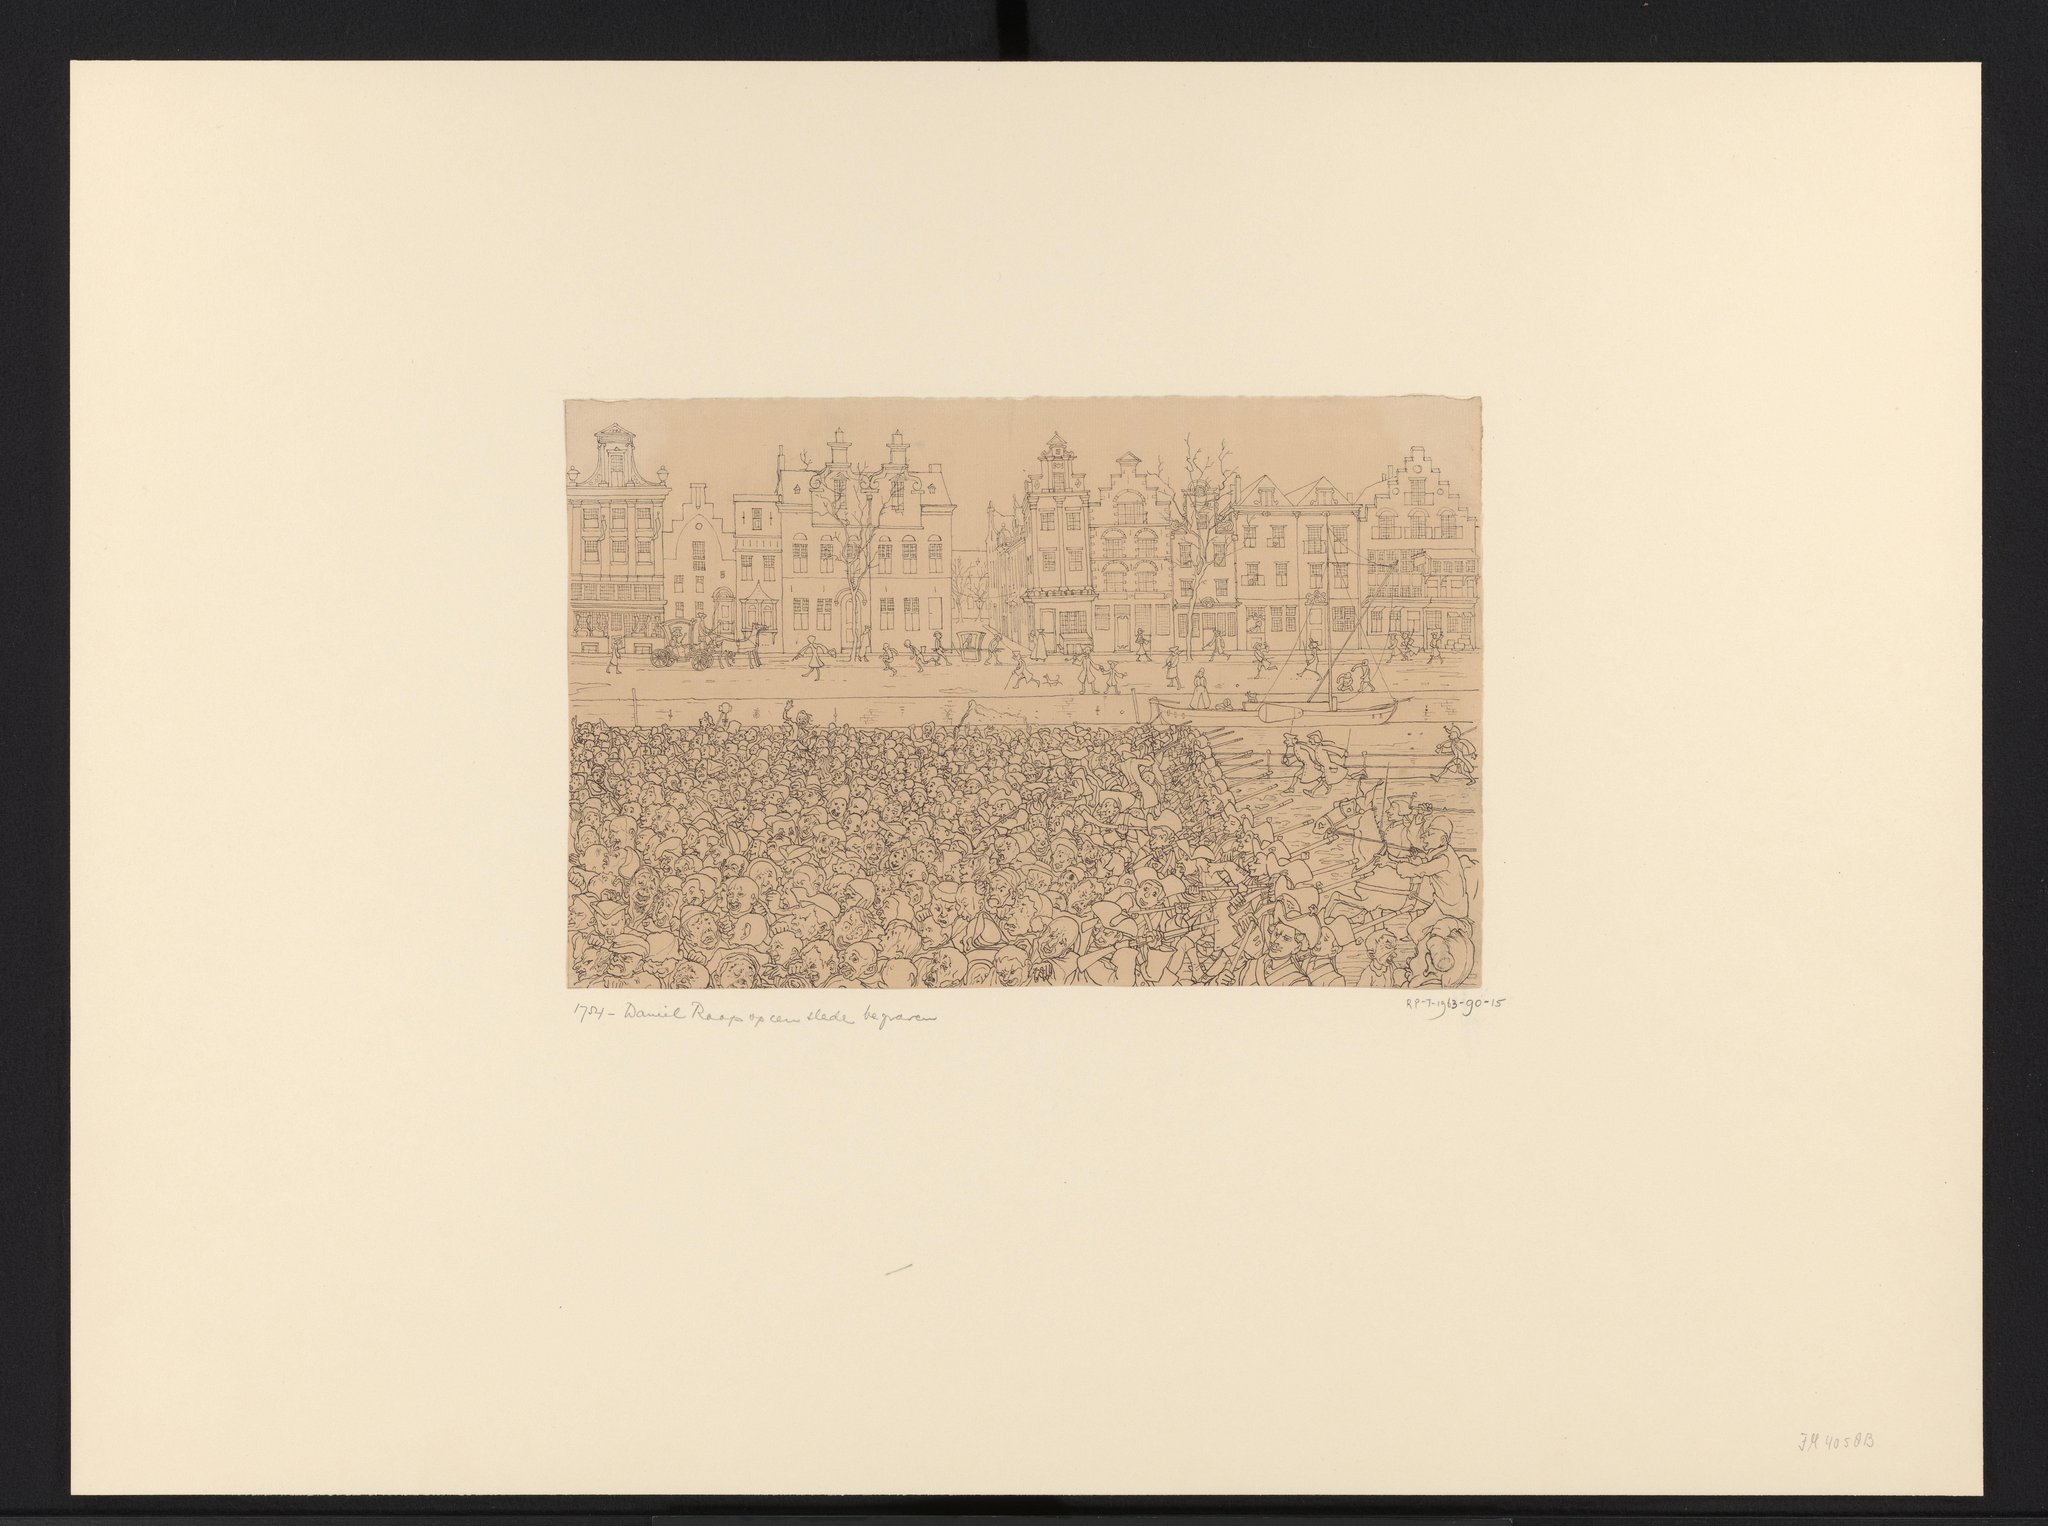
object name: drawing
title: 1754 / Daniel Raap op een slede begraven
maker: johan huizinga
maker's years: 1872-1945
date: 1893-1895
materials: ink, paper, pencil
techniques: pen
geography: netherlands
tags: funerary ceremonial, street-fights, riots, amsterdam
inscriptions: collector's mark: Lugt 2228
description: Volksmenigte bij de begrafenis van de koopman en orangist Daniël Raap, Amsterdam 15 januari 1754. Raap was woordvoerder van de Doelisten die zich verzetten tegen corrupte bestuurders en pleitte voor verheffing van Willem IV tot stadhouder. Onderdeel van de map met 18 tekeningen gereproduceerd in Johan Huizinga's 'Keur van gedenkwaardige tafereelen uit de vaderlandsche historiën' uit 1950.